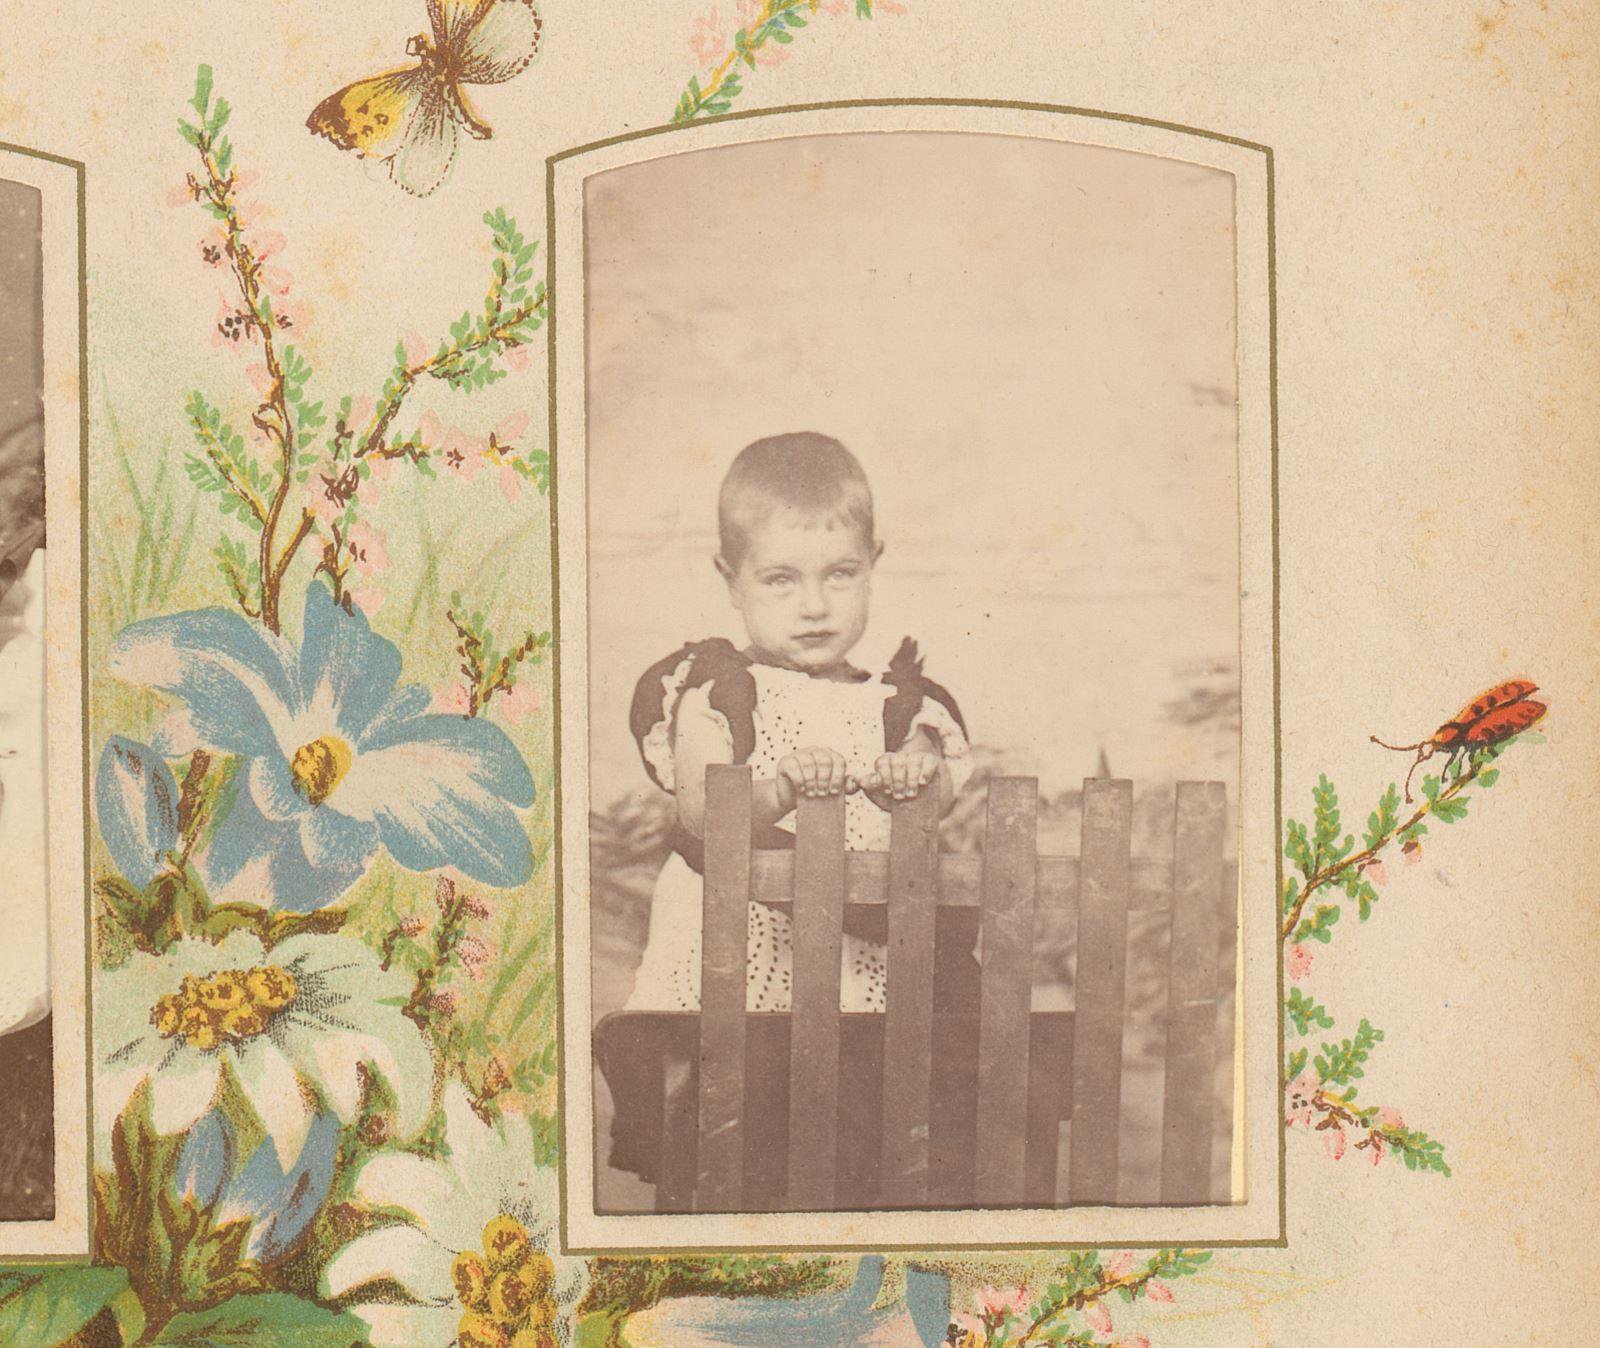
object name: album leaf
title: Portret van een peuter bij een hek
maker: Anonymous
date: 1860-1900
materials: cardboard, photographic support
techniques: albumen print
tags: toddler, historical persons